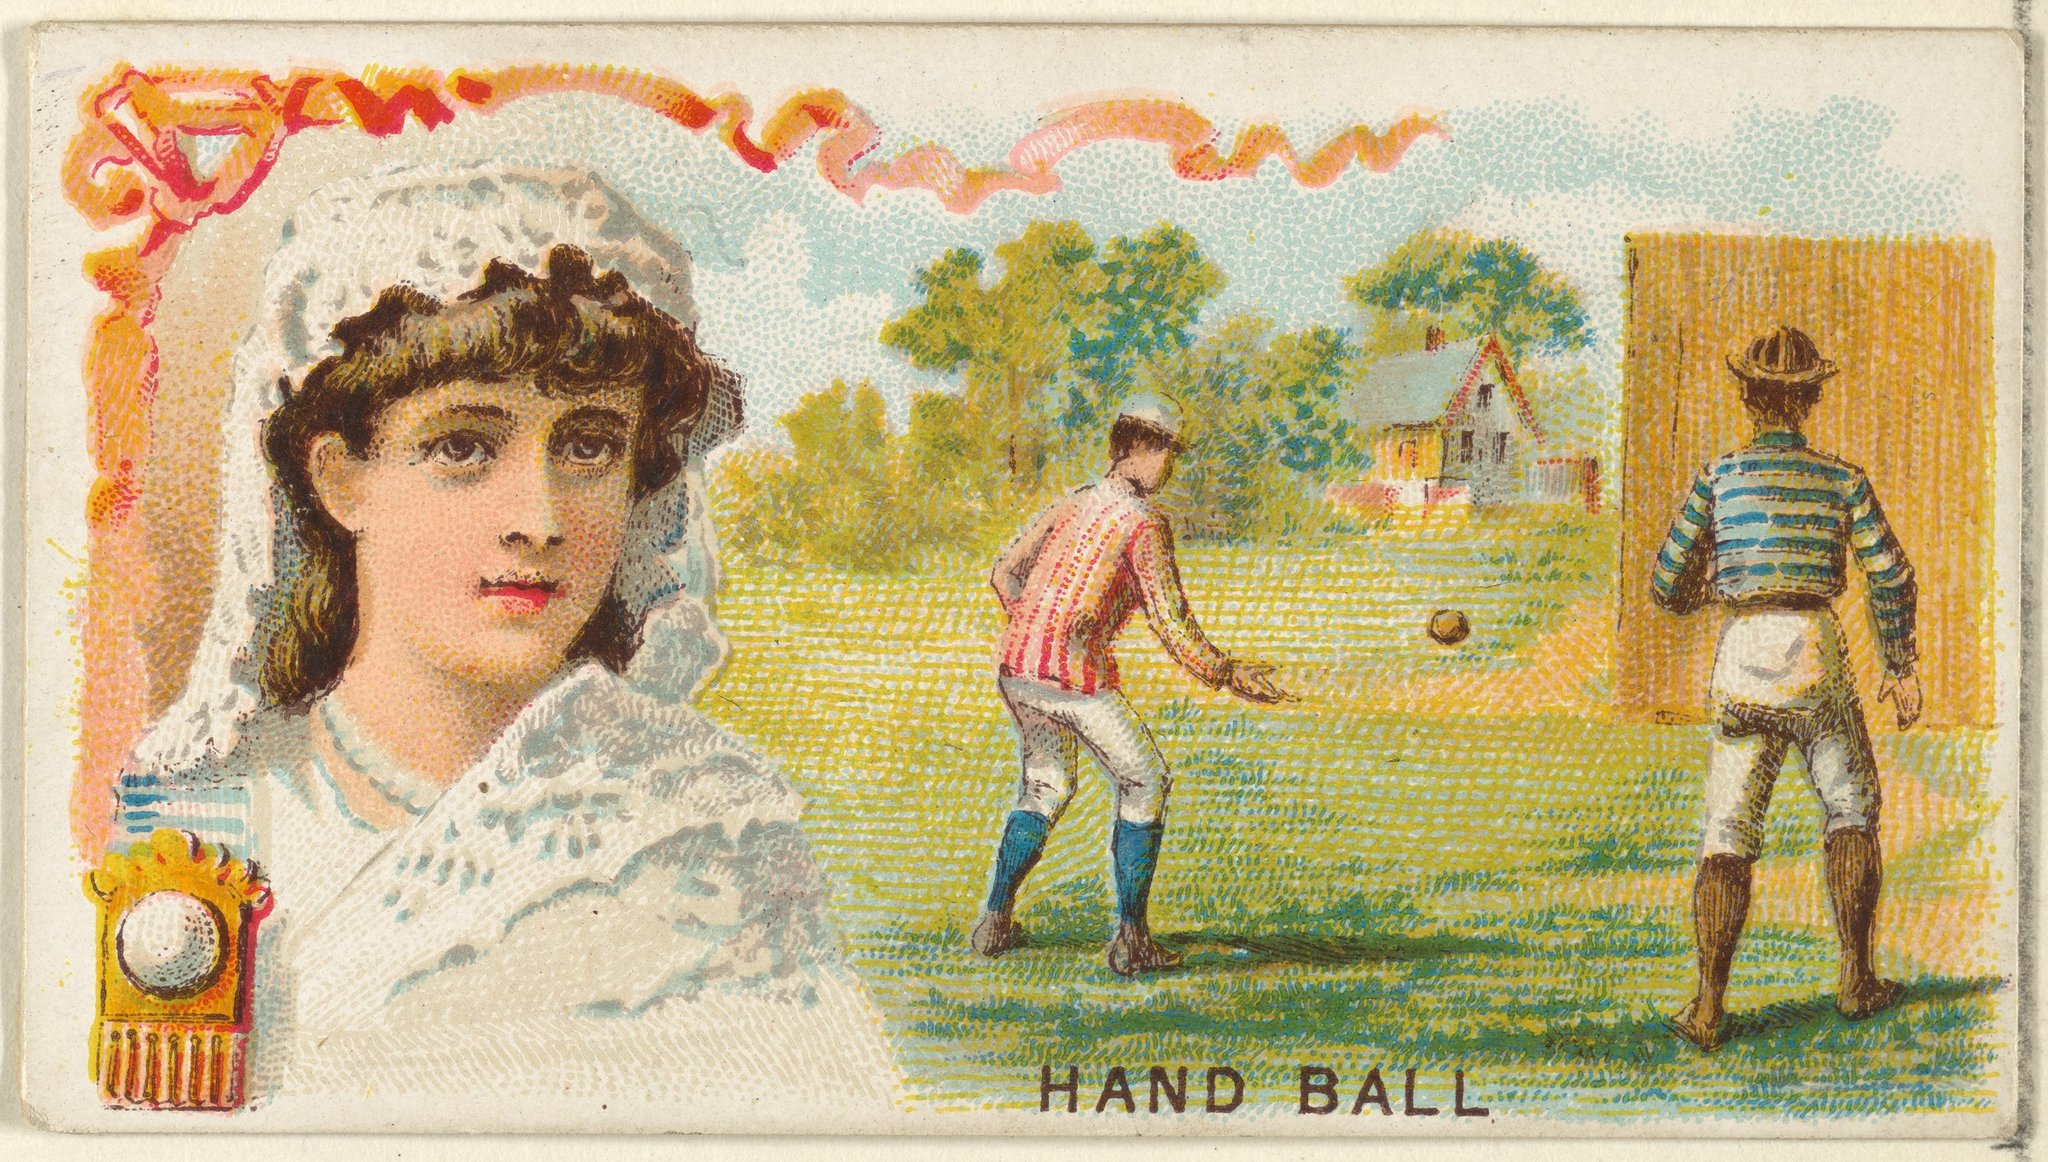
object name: print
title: Handball, from the Games and Sports series (N165) for Old Judge Cigarettes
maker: goodwin & company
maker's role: publisher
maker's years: 1850-1950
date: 1889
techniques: color lithograph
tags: men,women,sports